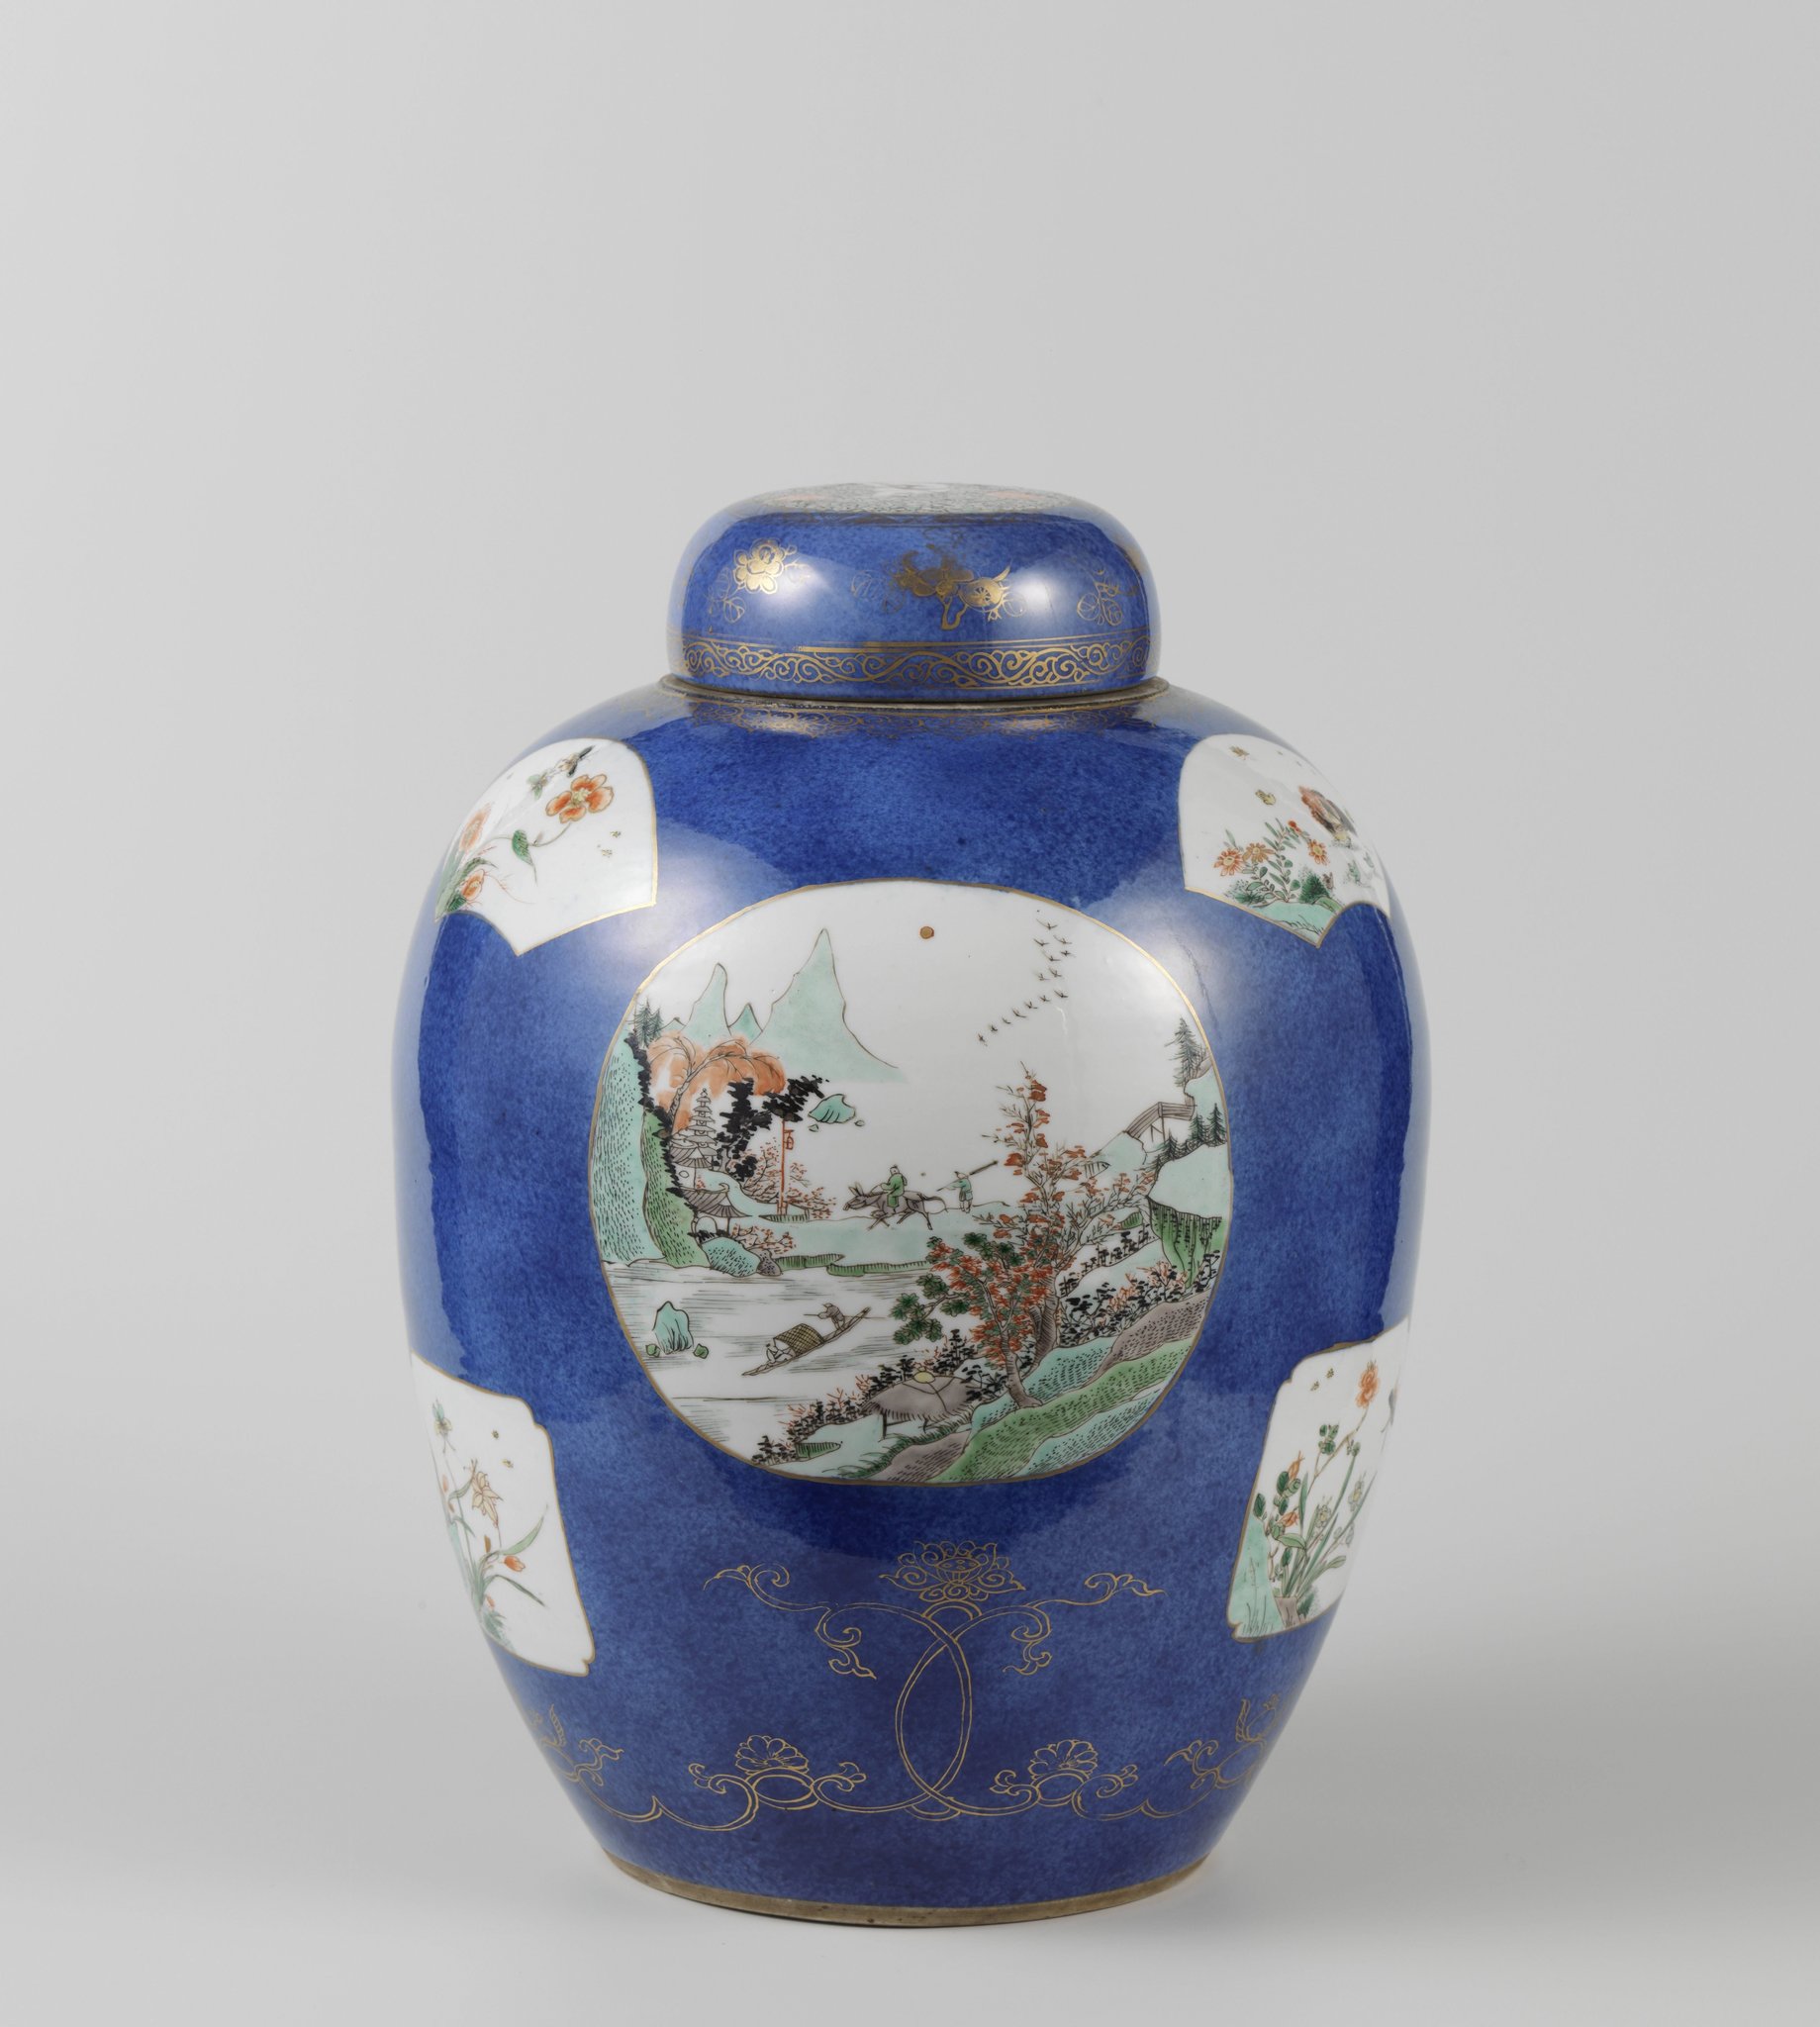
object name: lid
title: Ovoid covered jar with powder blue and panels in reserve with lanscape, flower basket and antiquities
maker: Anonymous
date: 1700-1724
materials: cobalt, glaze, gold, paint, porcelain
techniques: firing, gilding, turning, vitrification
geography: china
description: Deksel van pot van porselein, beschilderd in onderglazuur blauw en op het glazuur rood, groen, geel, aubergine, zwart en goud. De deksel is bedekt met bleu poudré en een medaillon in reserve met krulwerk en een jongen (zotje) hangend aan een bloemtak tegen een groene achtergrond, de wand met bloemtakken en een decoratieve band in goud. Bleu poudré met famille verte.